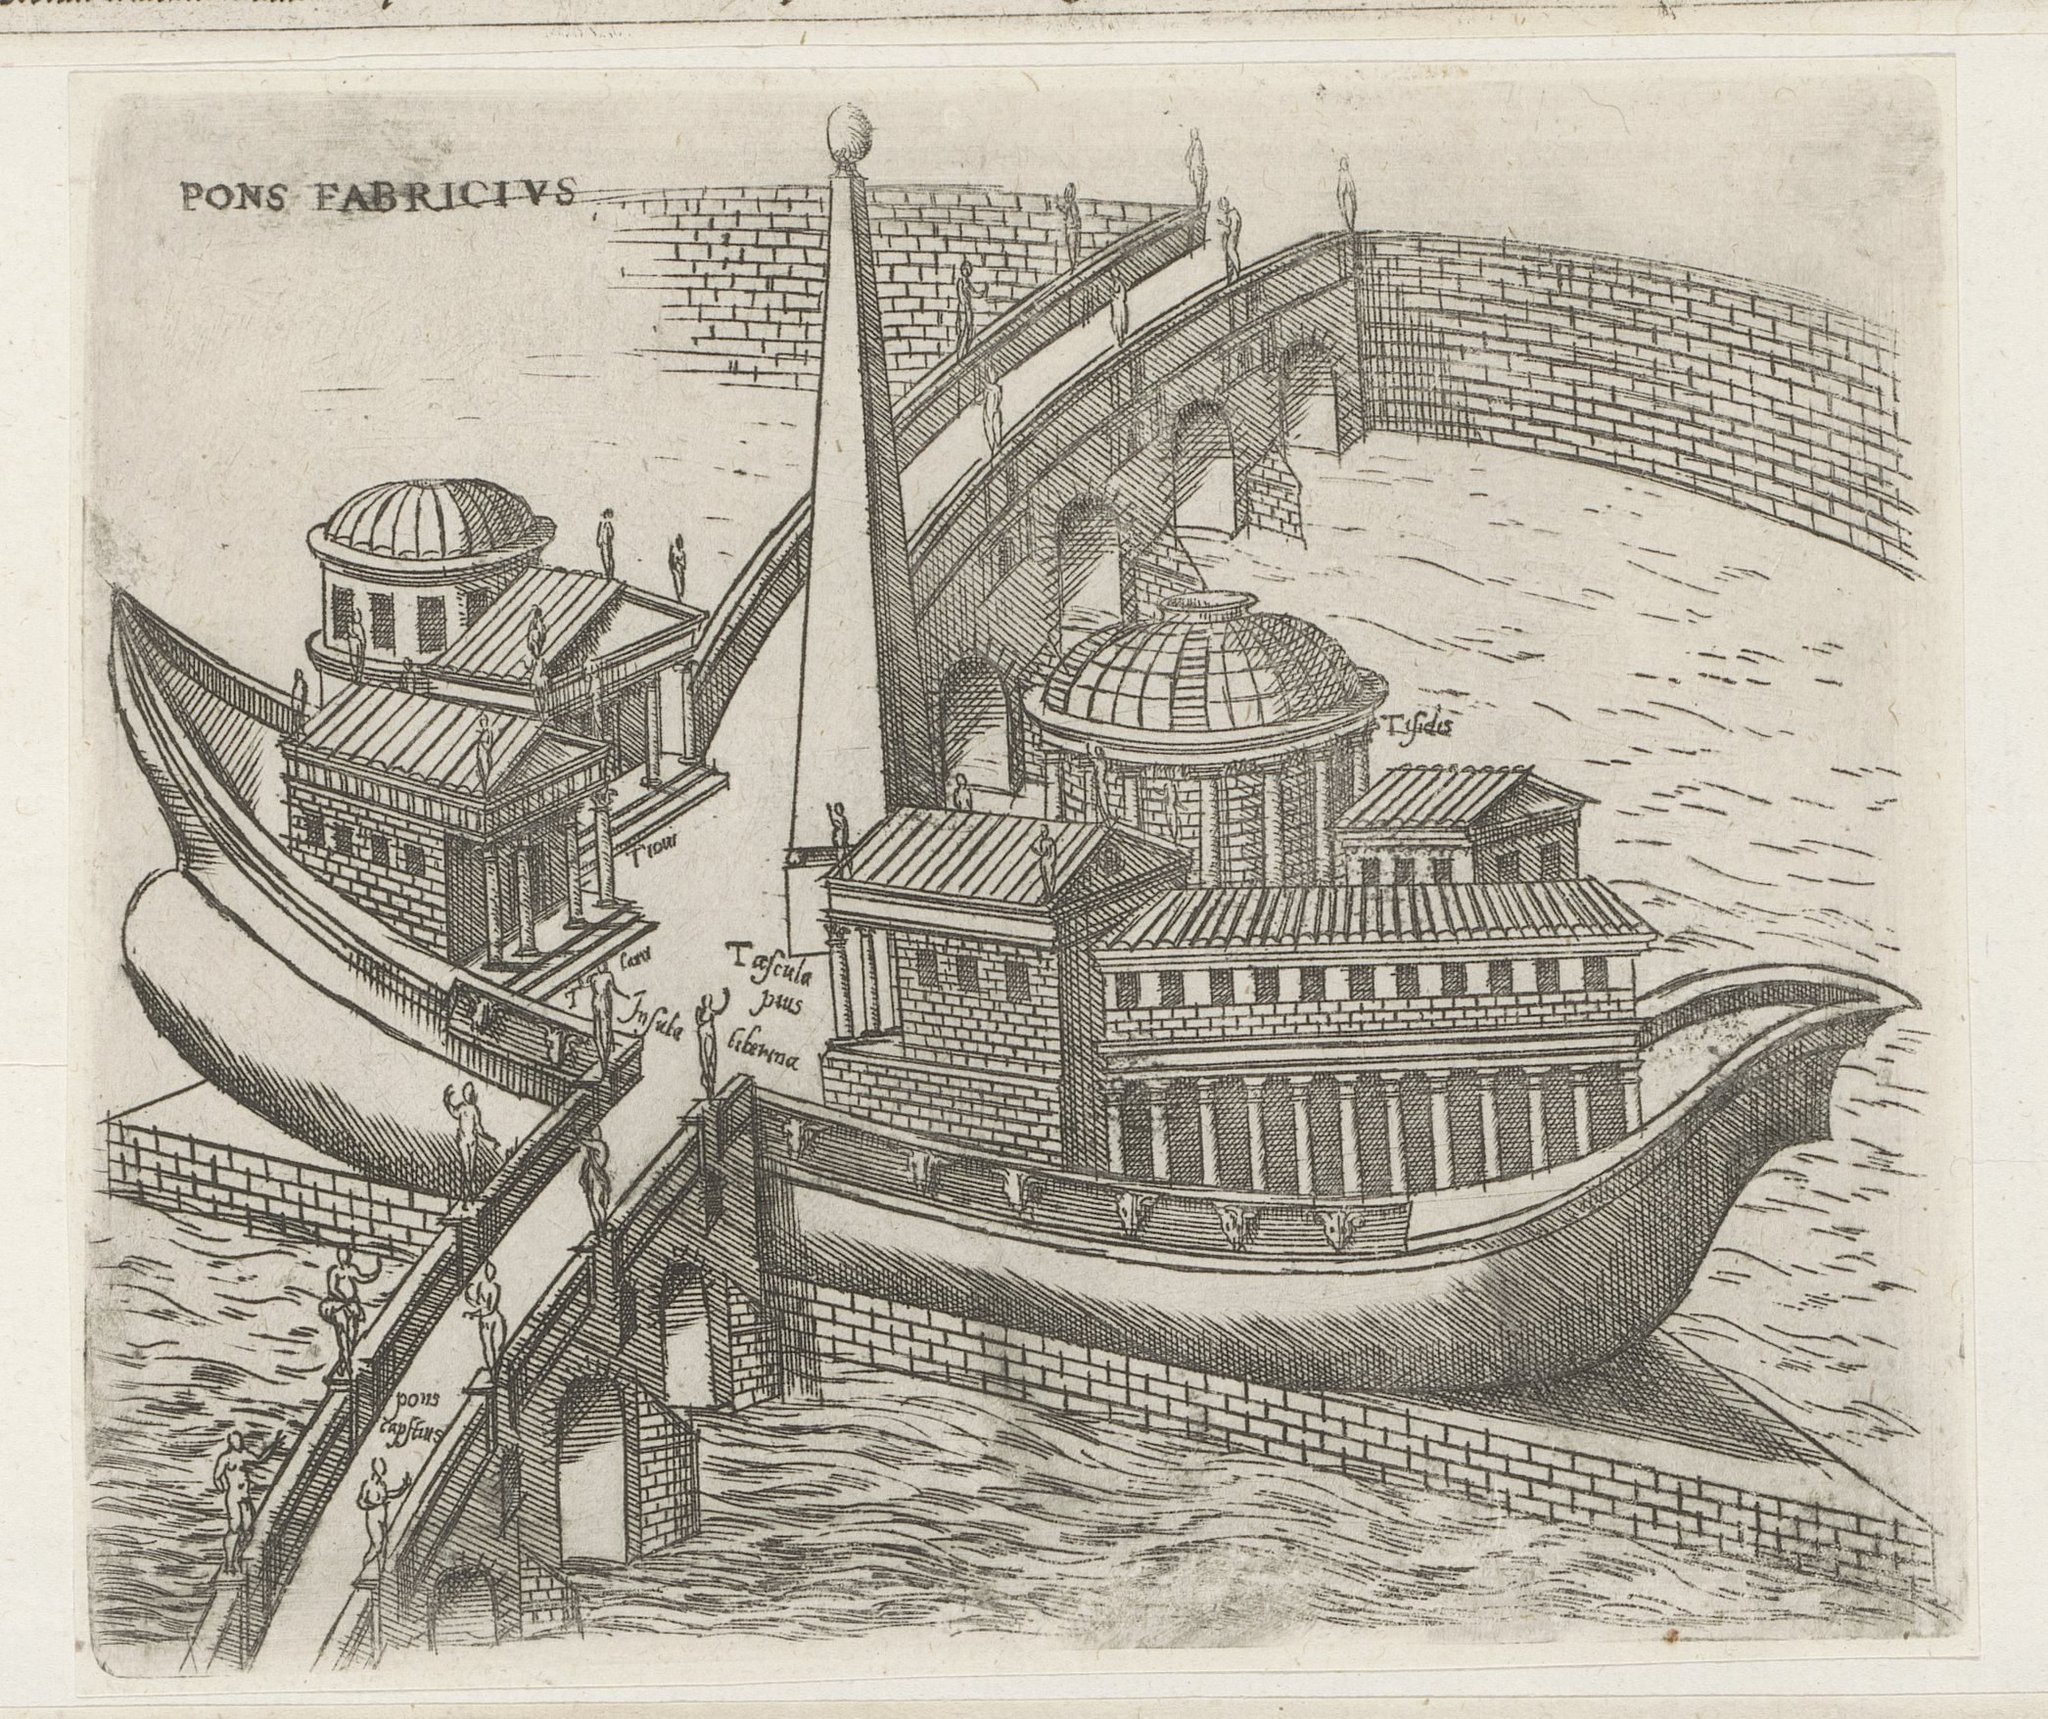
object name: album leaf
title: Magesyn der Italiaense gebouwen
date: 1584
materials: paper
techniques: etching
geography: france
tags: representation of real building (either existing or having existed), bridge in city across river, canal, etc.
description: Deze prent maakt deel uit van een serie van 98 prenten gedrukt op 48 bladen. De bladen zijn verknipt en een selectie van de losse prenten is in dit album geplakt.